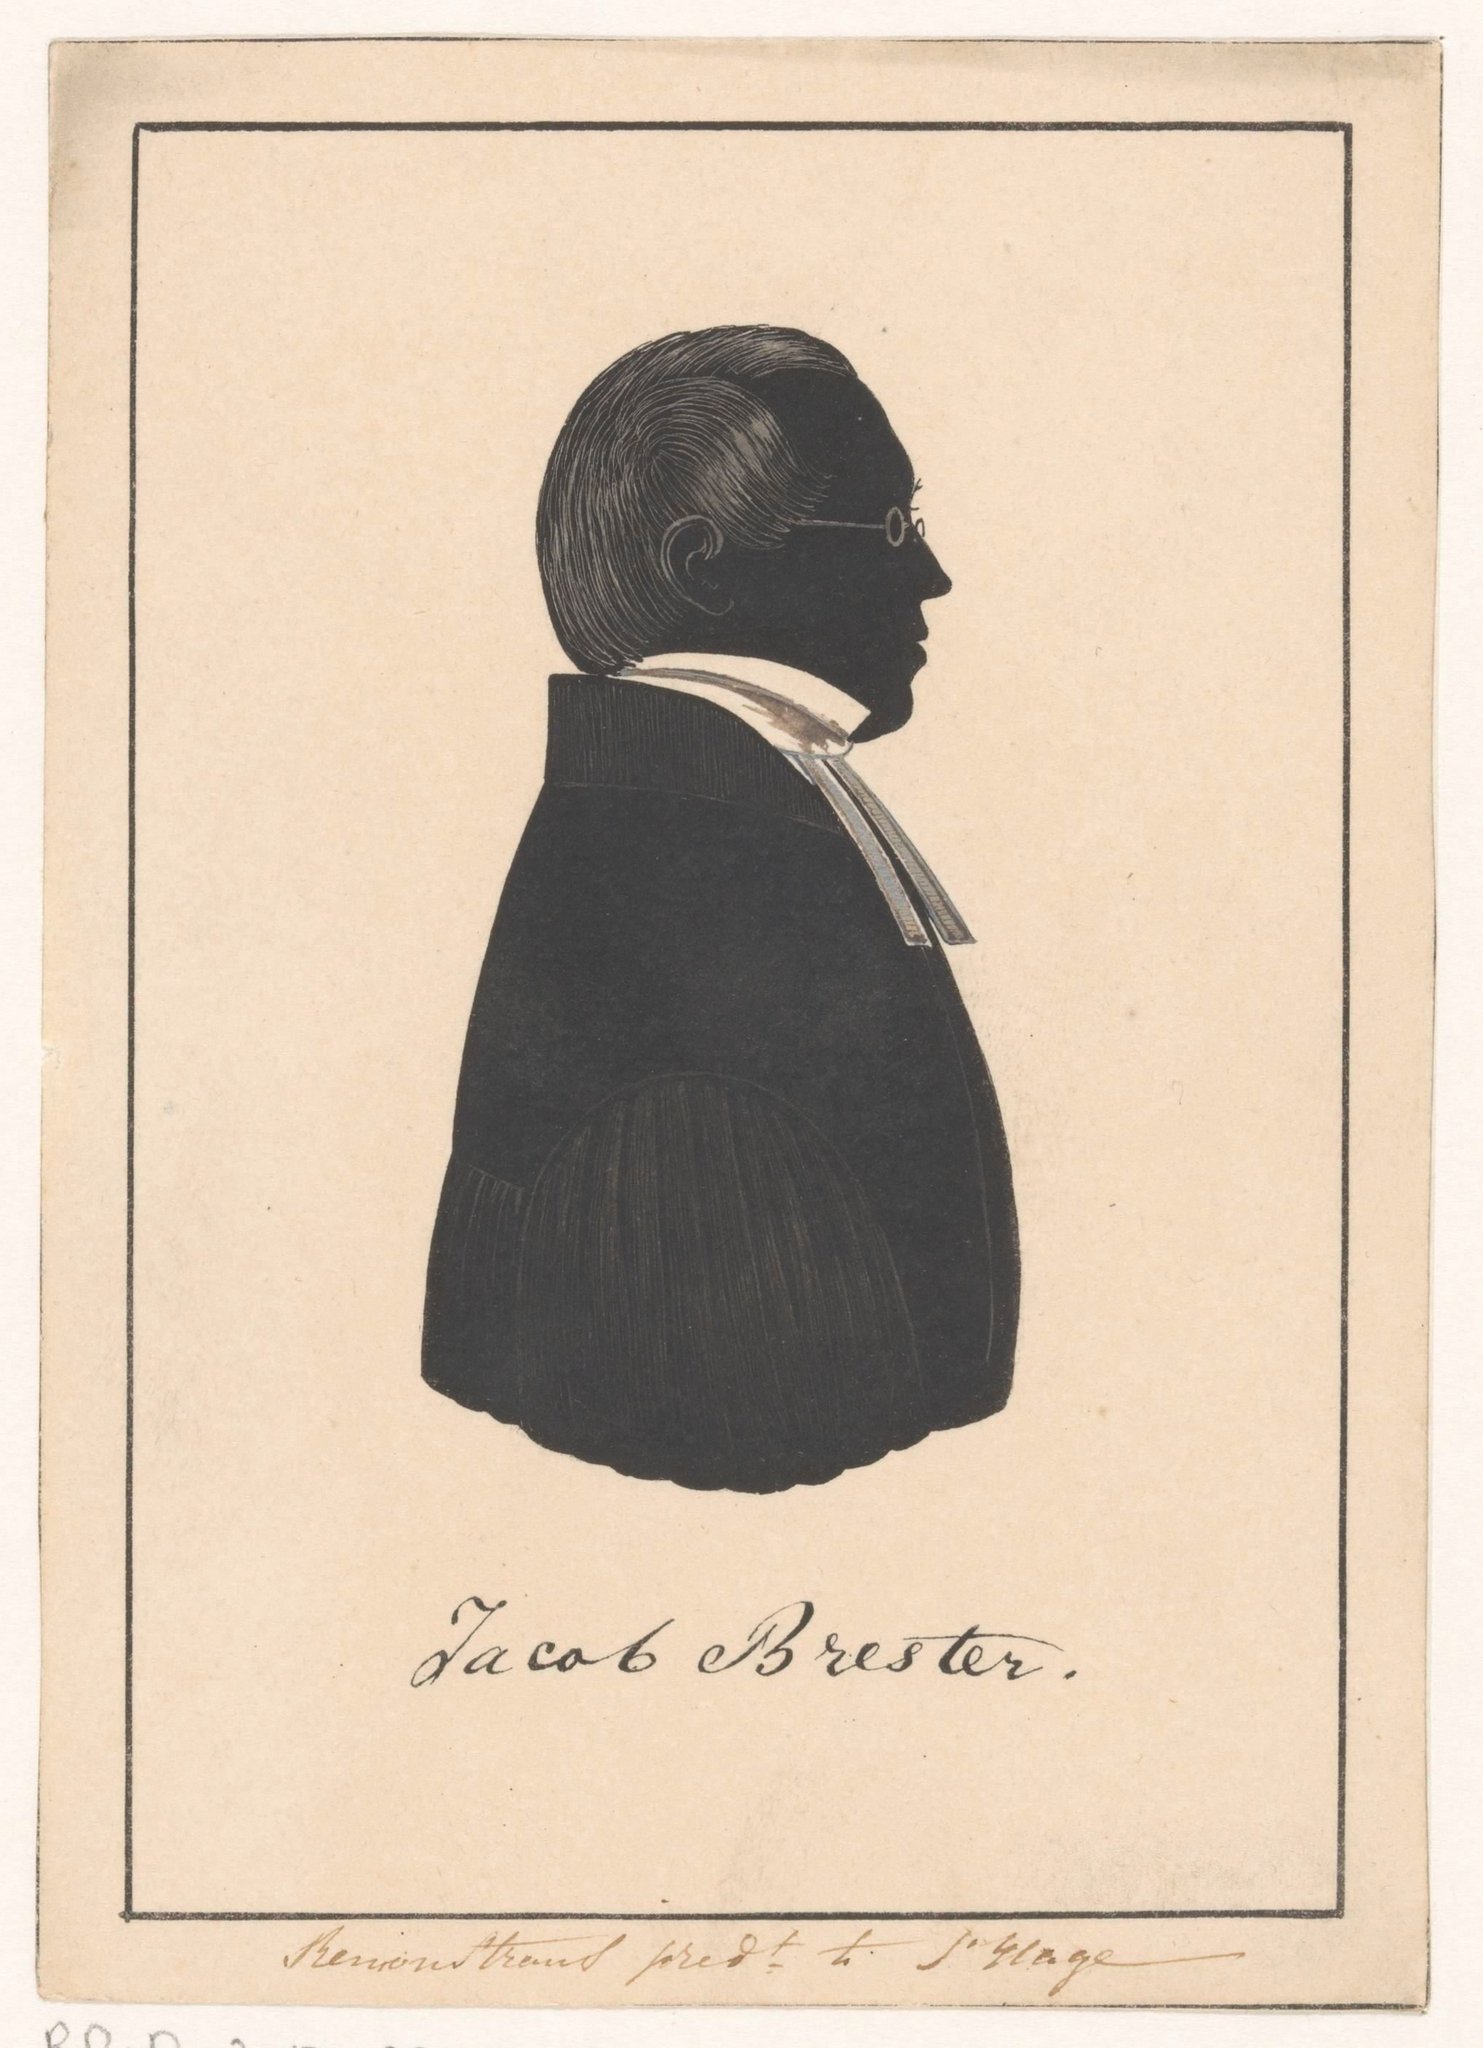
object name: print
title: Silhouetportret van Jacob Brester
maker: pieter barbiers (iv)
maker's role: painter, print maker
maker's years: 1798-1848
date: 1809-1848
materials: paper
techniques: hand coloring, lithograph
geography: netherlands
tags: historical persons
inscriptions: collector's mark: Lugt 2228, inscription: ‘Remonstrand pred.t te 's Hage’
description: Onder het portret de signatuur van de geportretteerde.